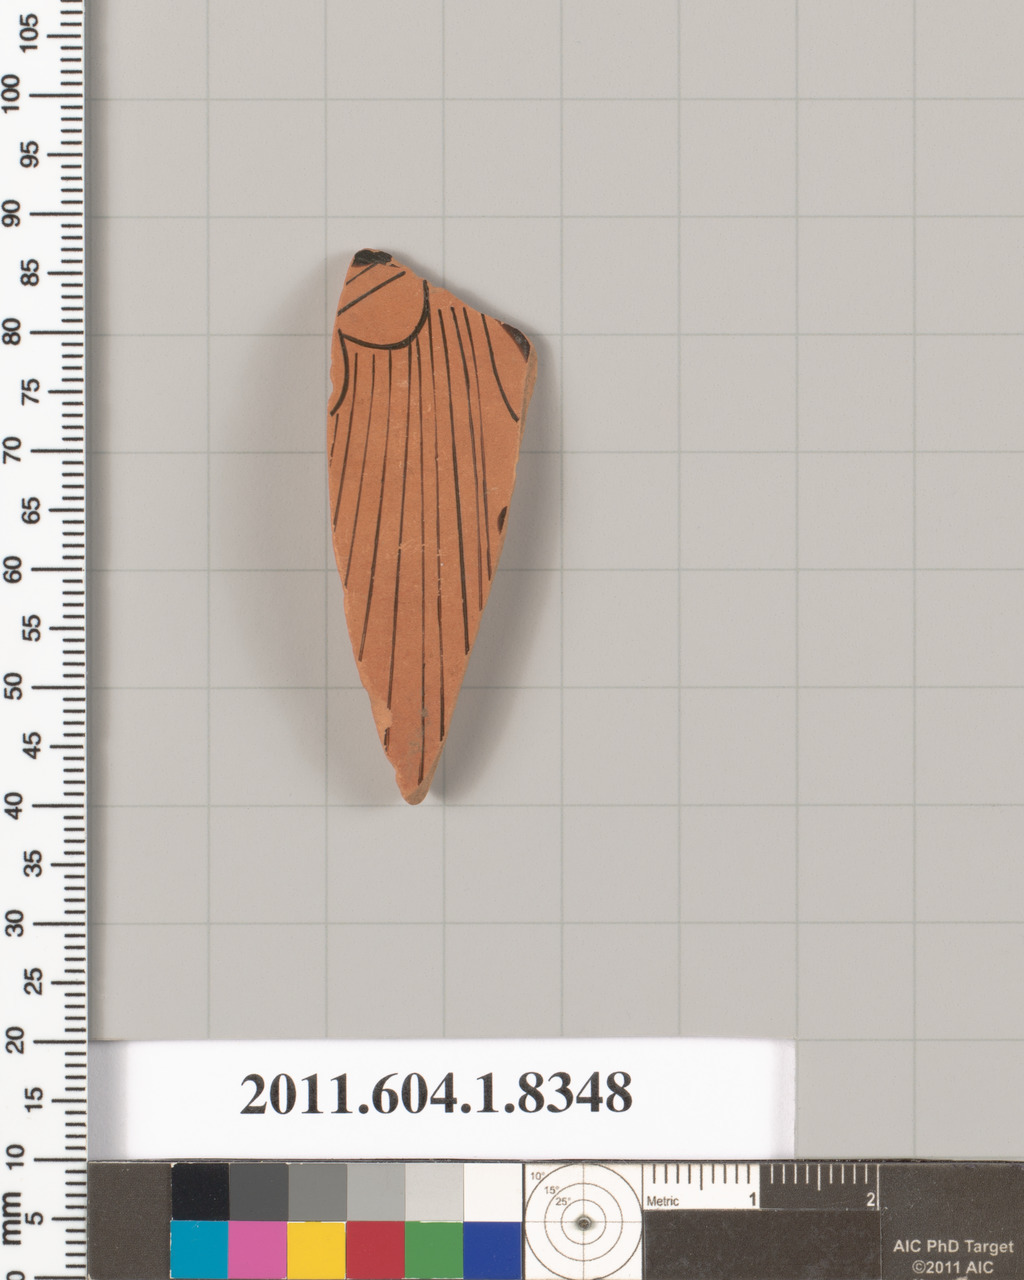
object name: kylix fragment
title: Terracotta fragment of a kylix (drinking cup)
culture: greek, attic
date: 450-426 BCE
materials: terracotta